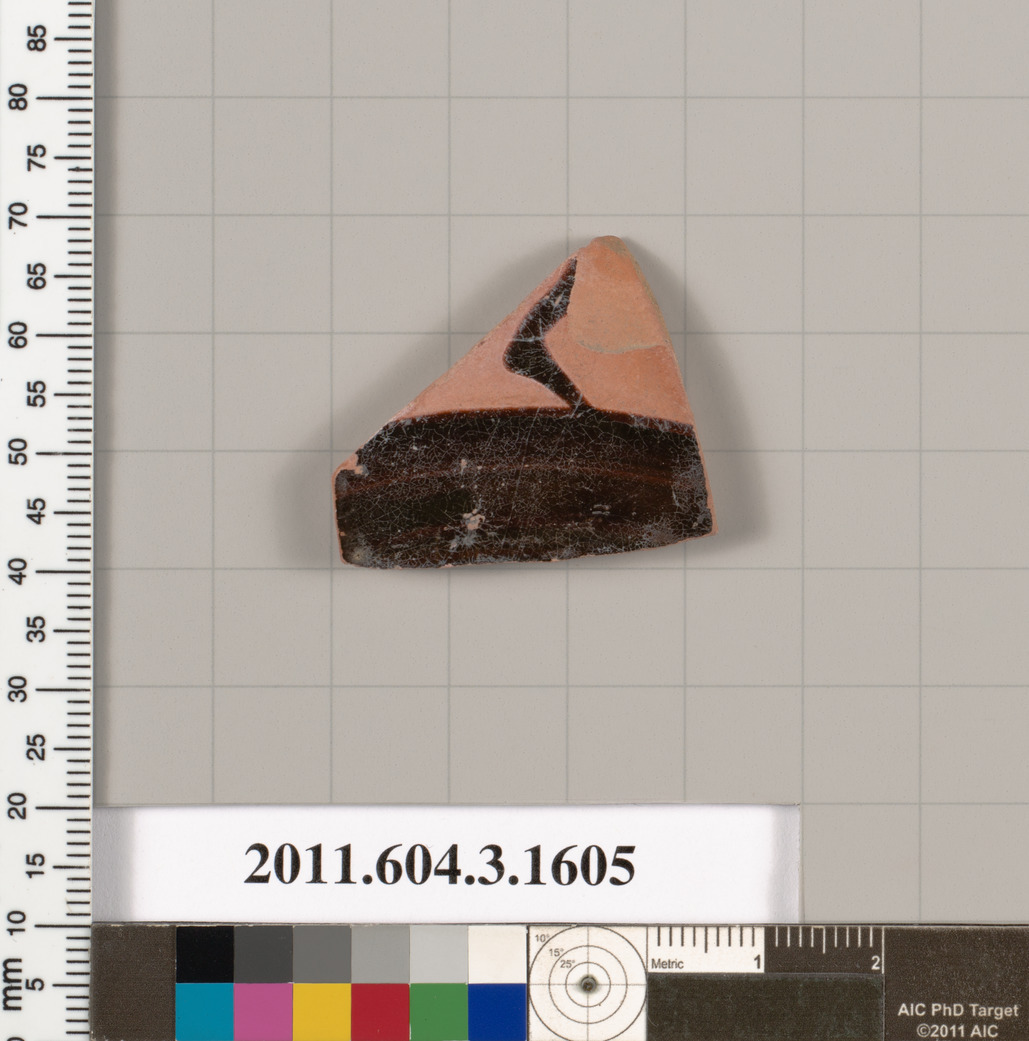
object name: kylix fragment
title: Terracotta fragment of a kylix: Band cup (drinking cup)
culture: greek, attic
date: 550-526 BCE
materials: terracotta